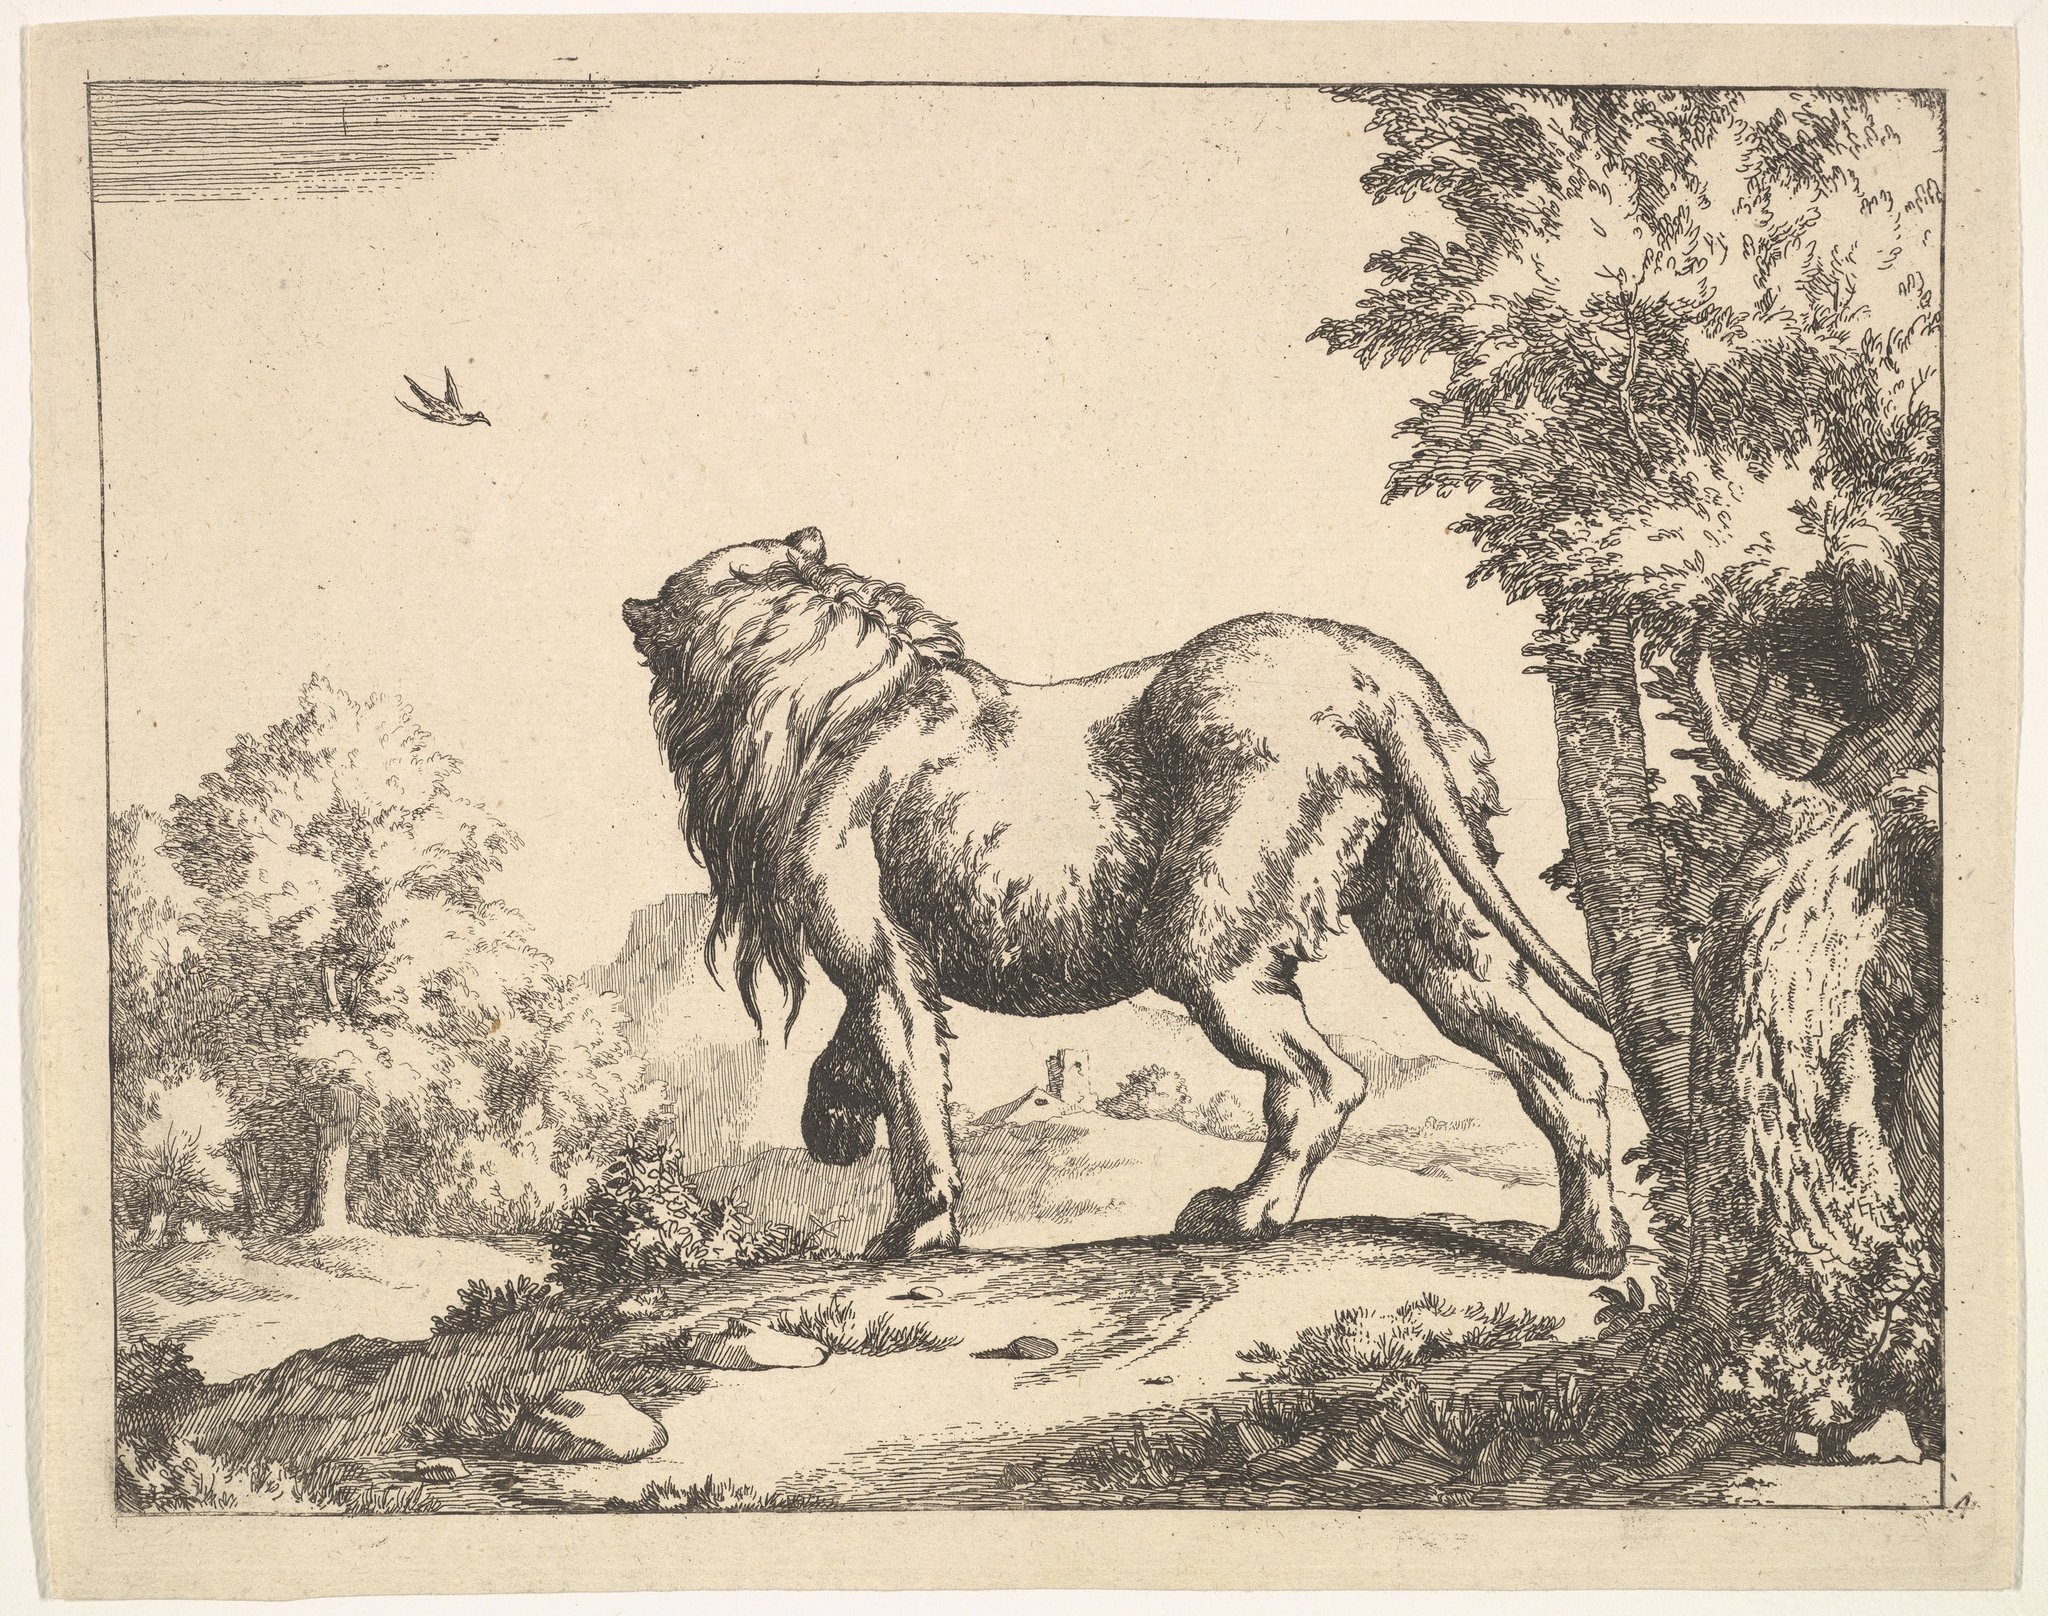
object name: print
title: Plate 4 from "The Lions"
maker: marcus de bye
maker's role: etcher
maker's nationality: dutch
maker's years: 1639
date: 1664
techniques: etching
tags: lions,trees